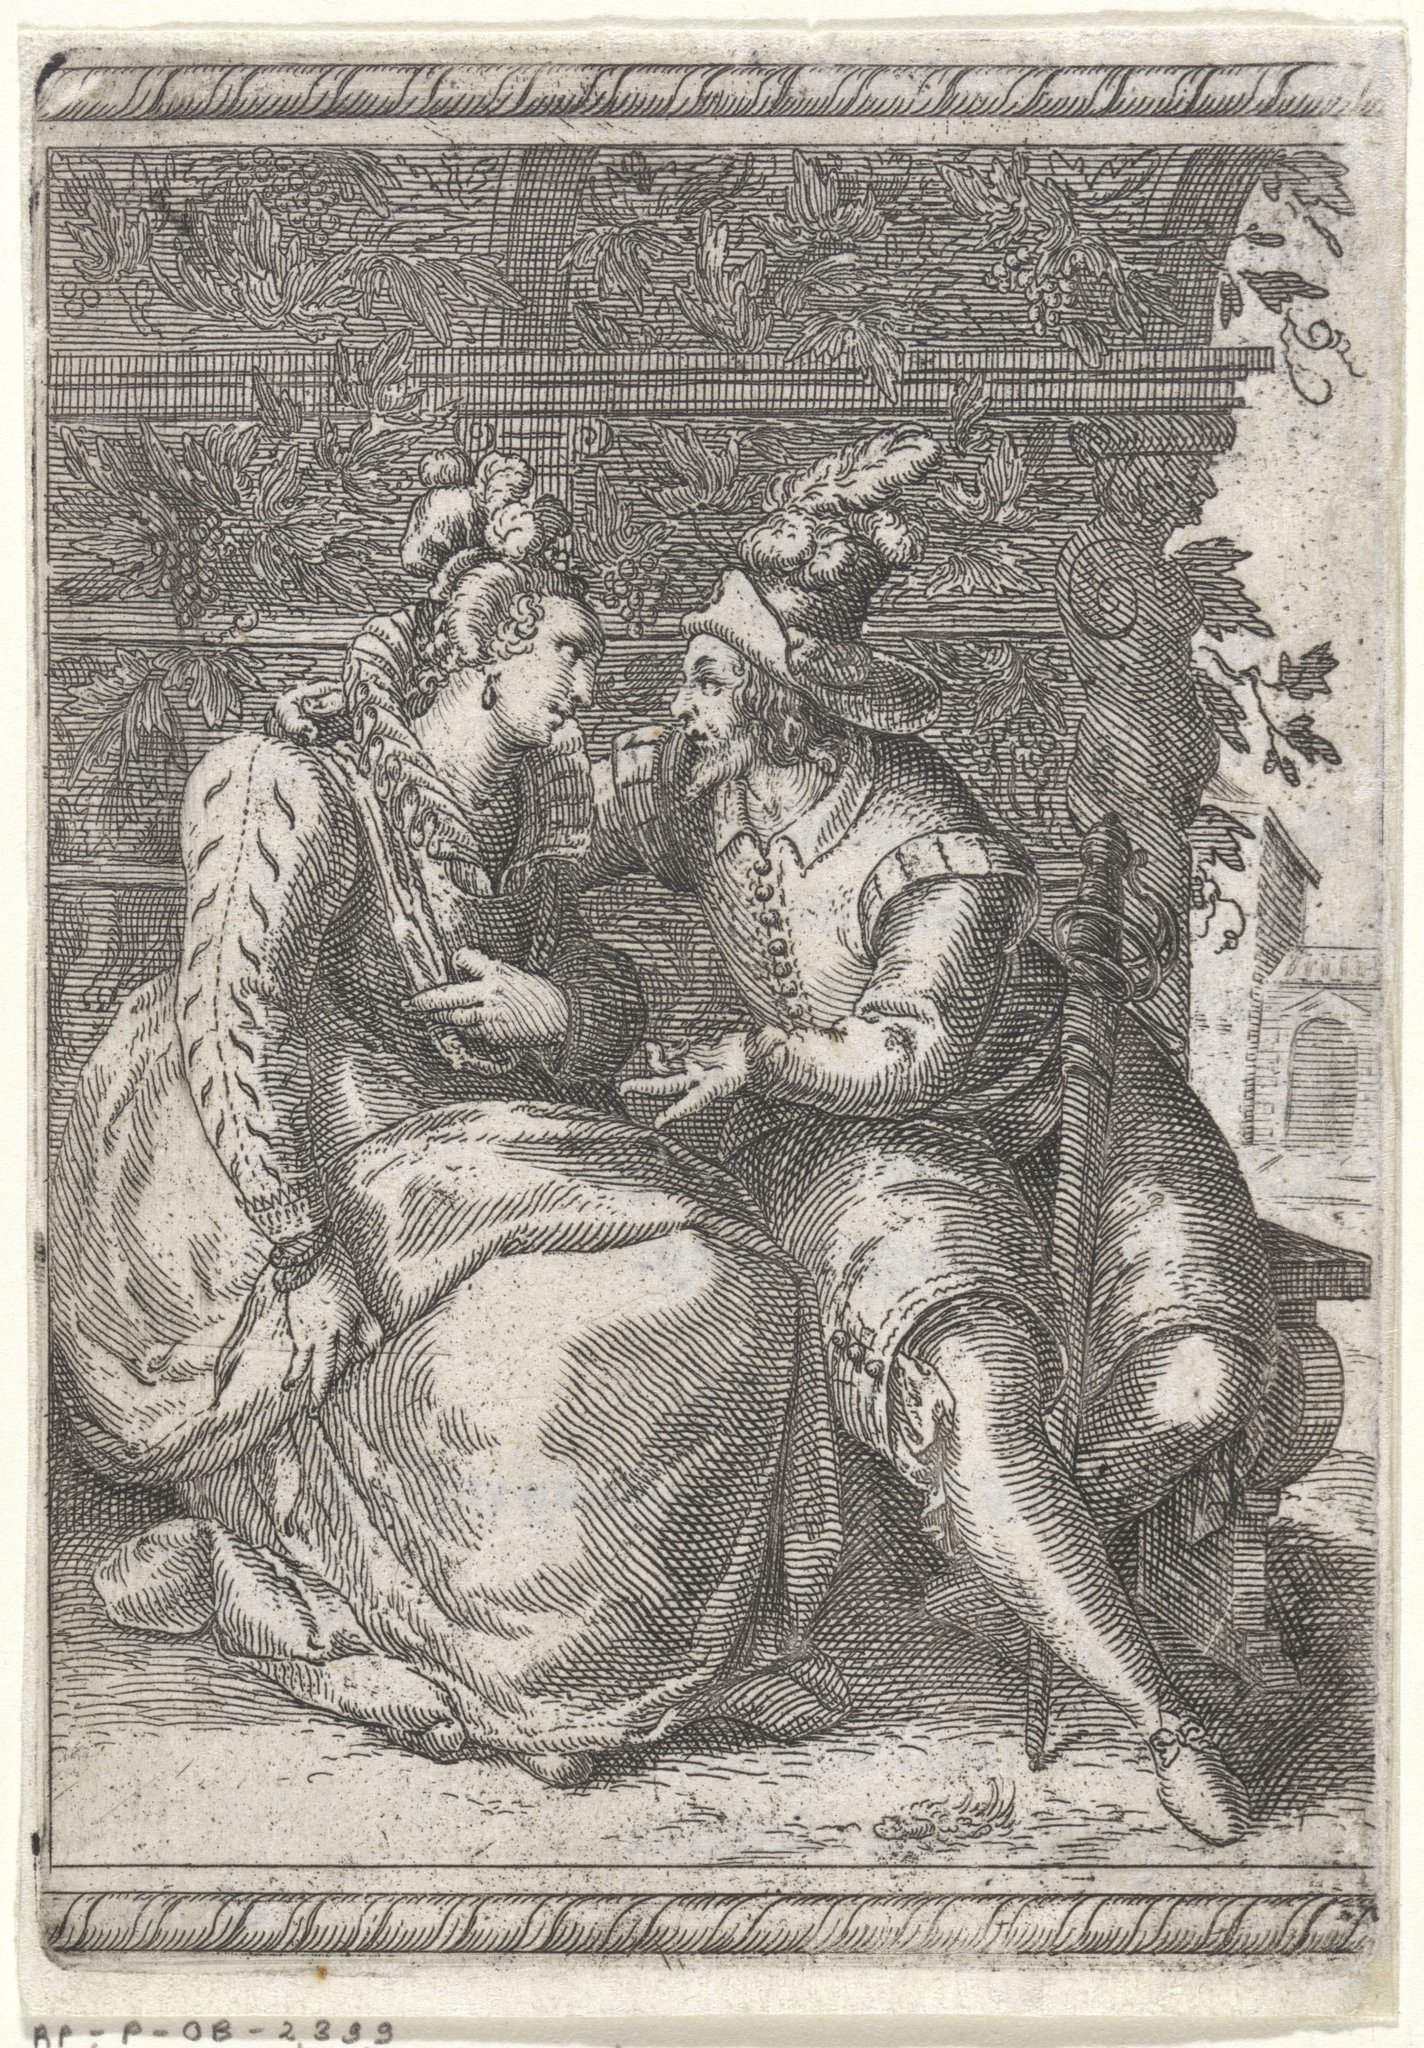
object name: print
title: Zittend elegant paar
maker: Anonymous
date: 1607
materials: paper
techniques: engraving, etching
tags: conversation, dialogue; conversation piece, couple of lovers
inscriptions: collector's mark: Lugt 2228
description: Deze prent is ook gebruikt als illustratie in: Vondel, Joost van den. Den nieuwen verbeterden lust-hof. Amsterdam: Dirck Pietersz Pers, 1607, p. 29.